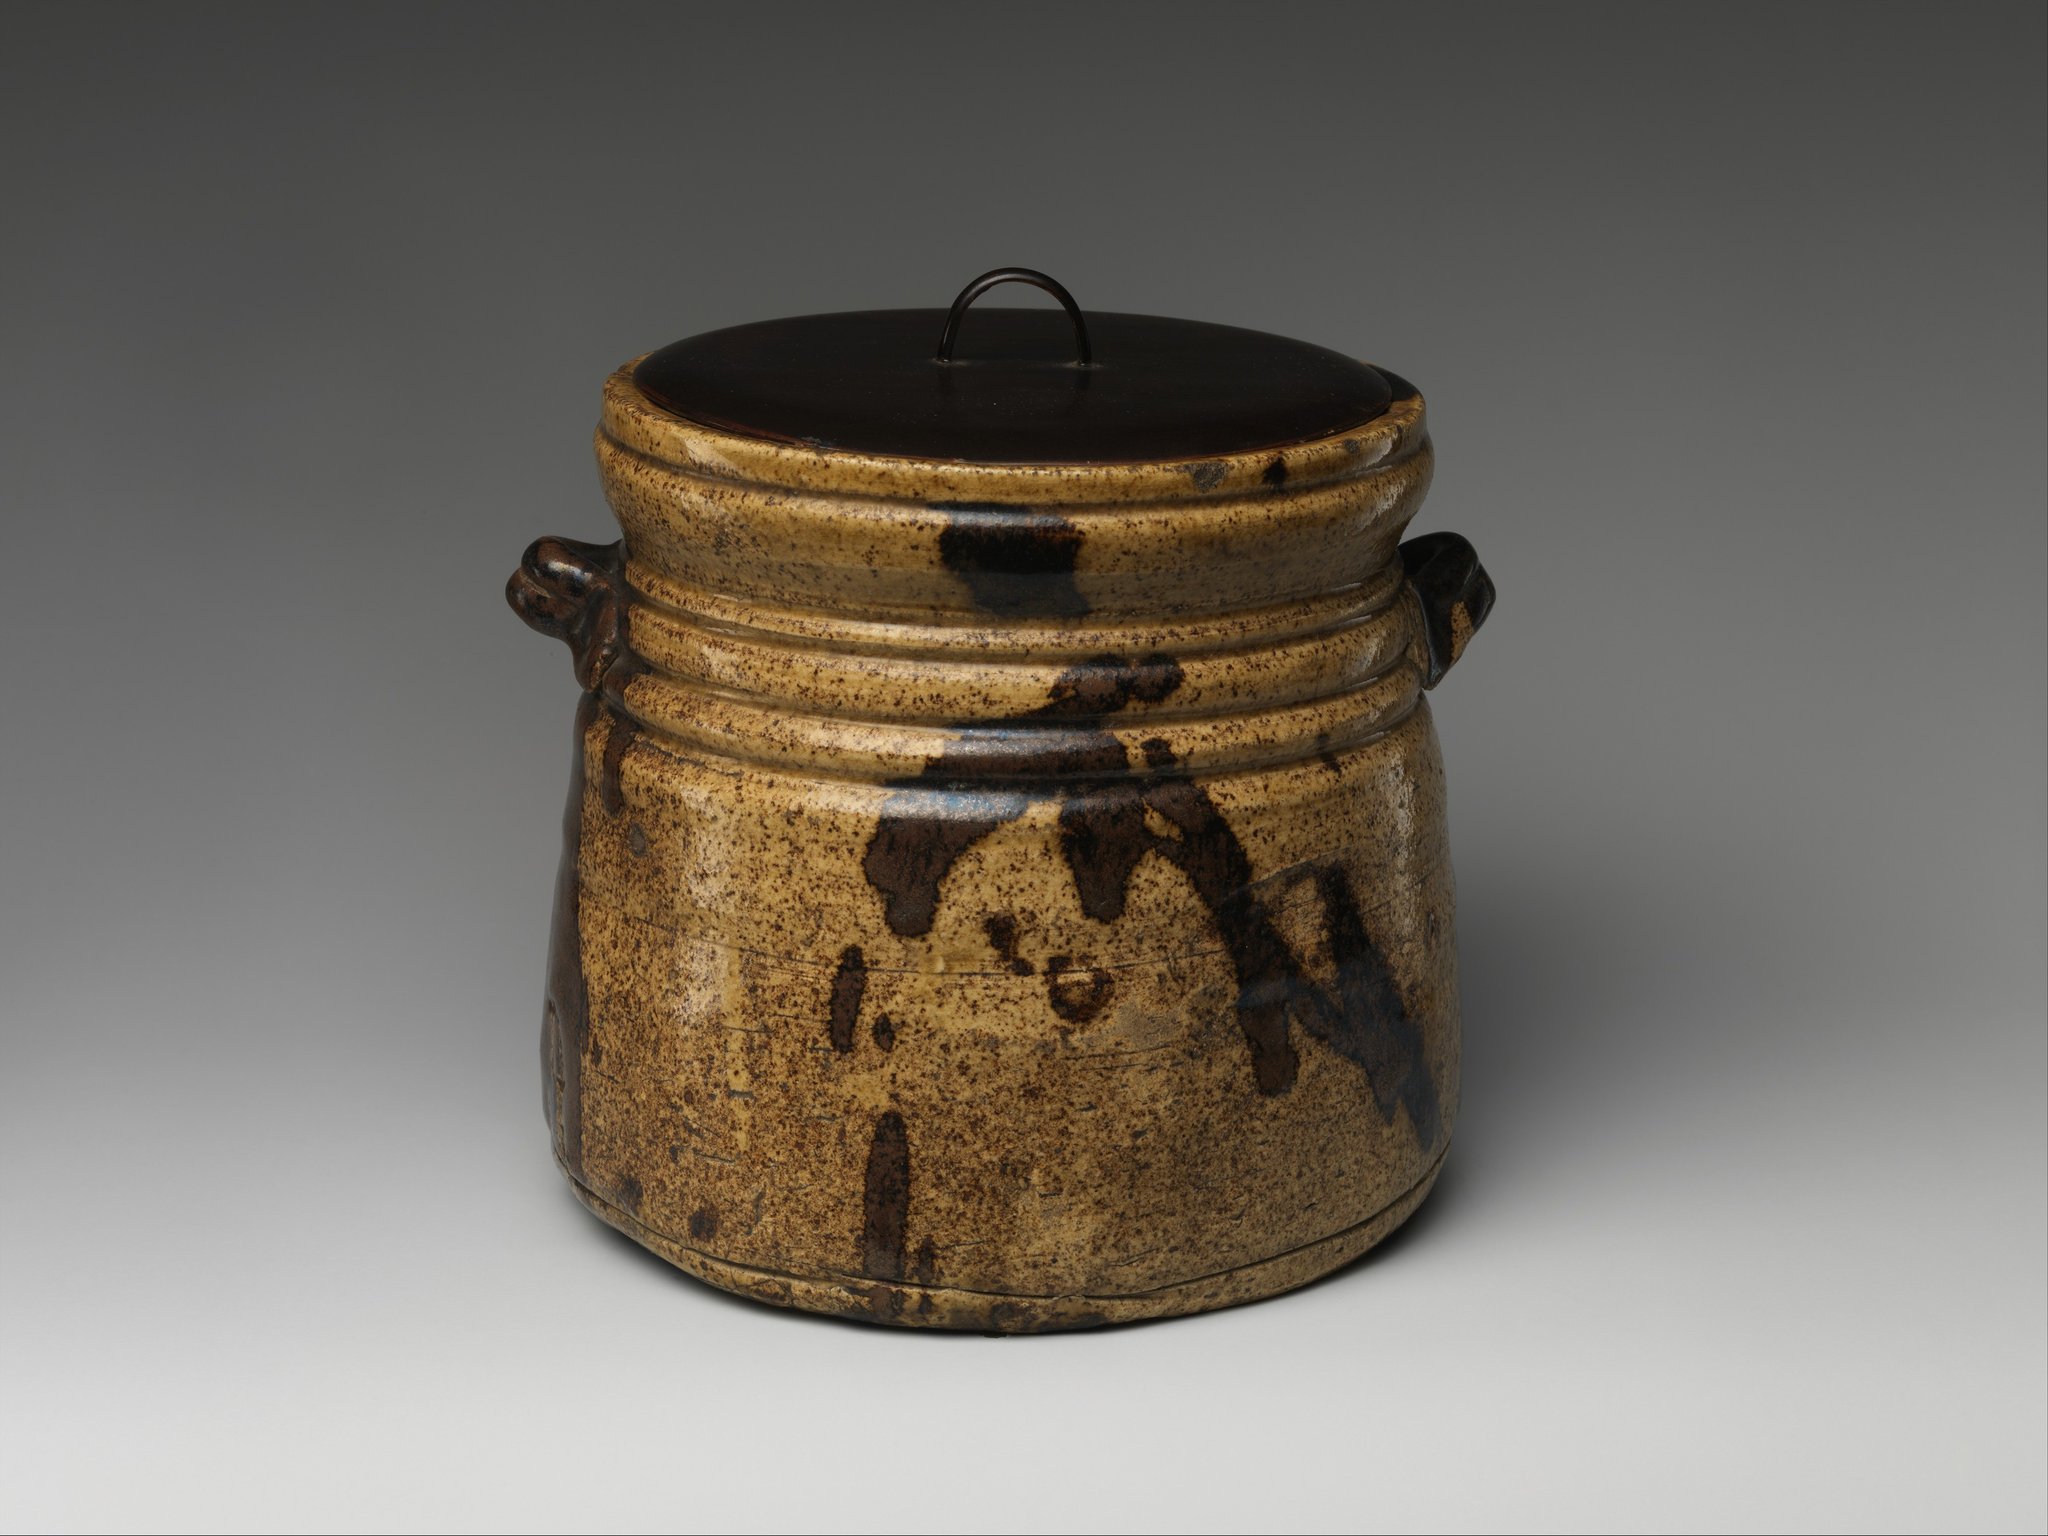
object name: water jar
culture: japanese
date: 1601-1700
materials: clay, glaze, iron, lacquer